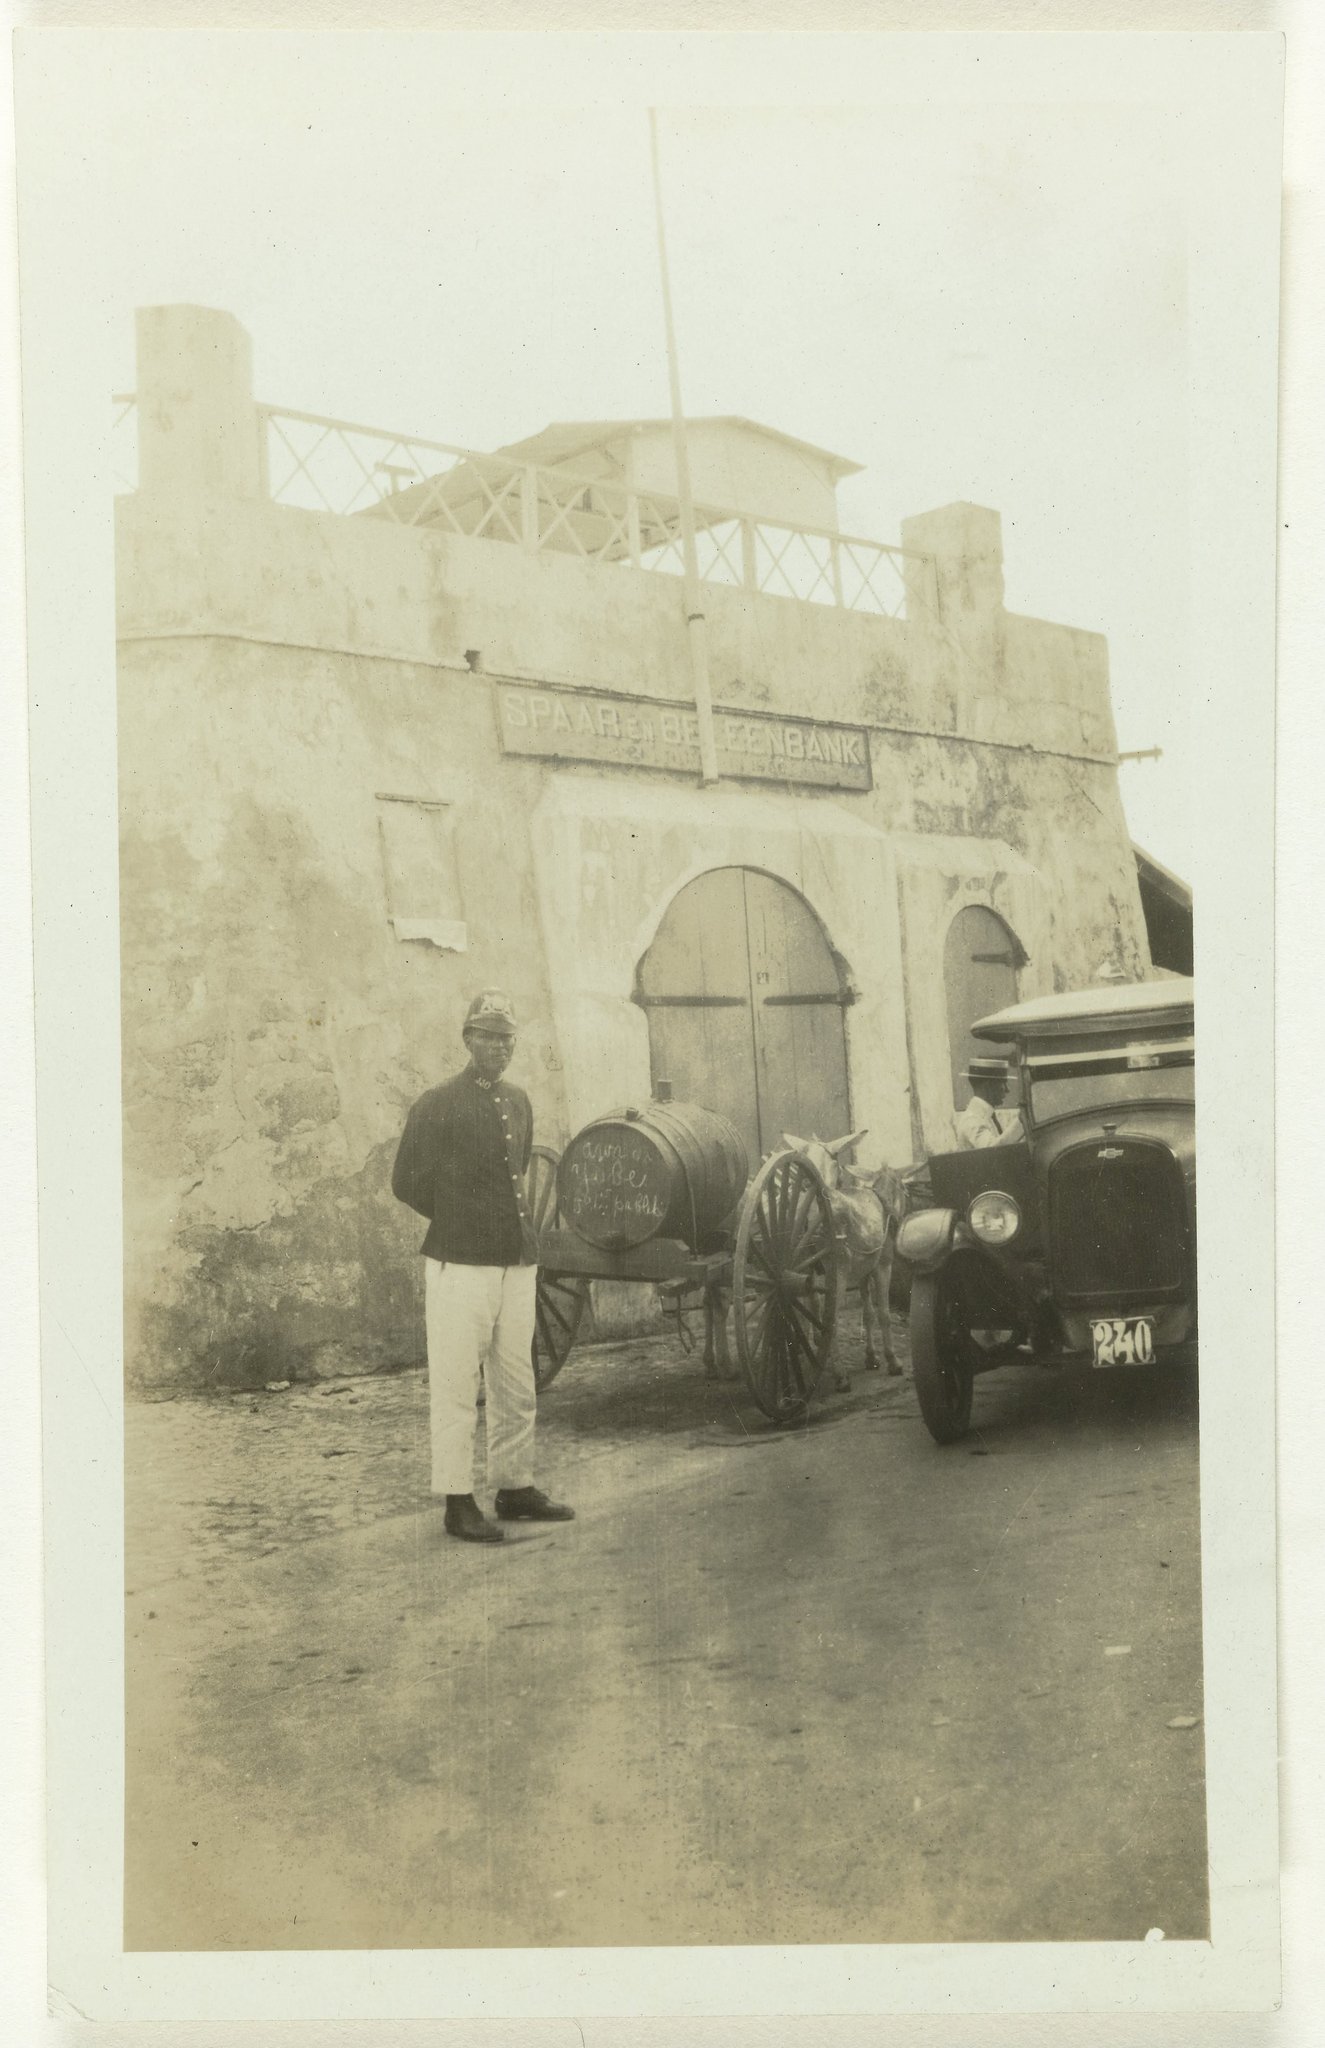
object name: photograph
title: Politieagent op Curaçao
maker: Anonymous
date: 1925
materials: photographic support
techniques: photography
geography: curacao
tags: policeman, constable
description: Geuniformeerde man staat voor fortachtig gebouw, met rechts een kar met een ton en een auto.